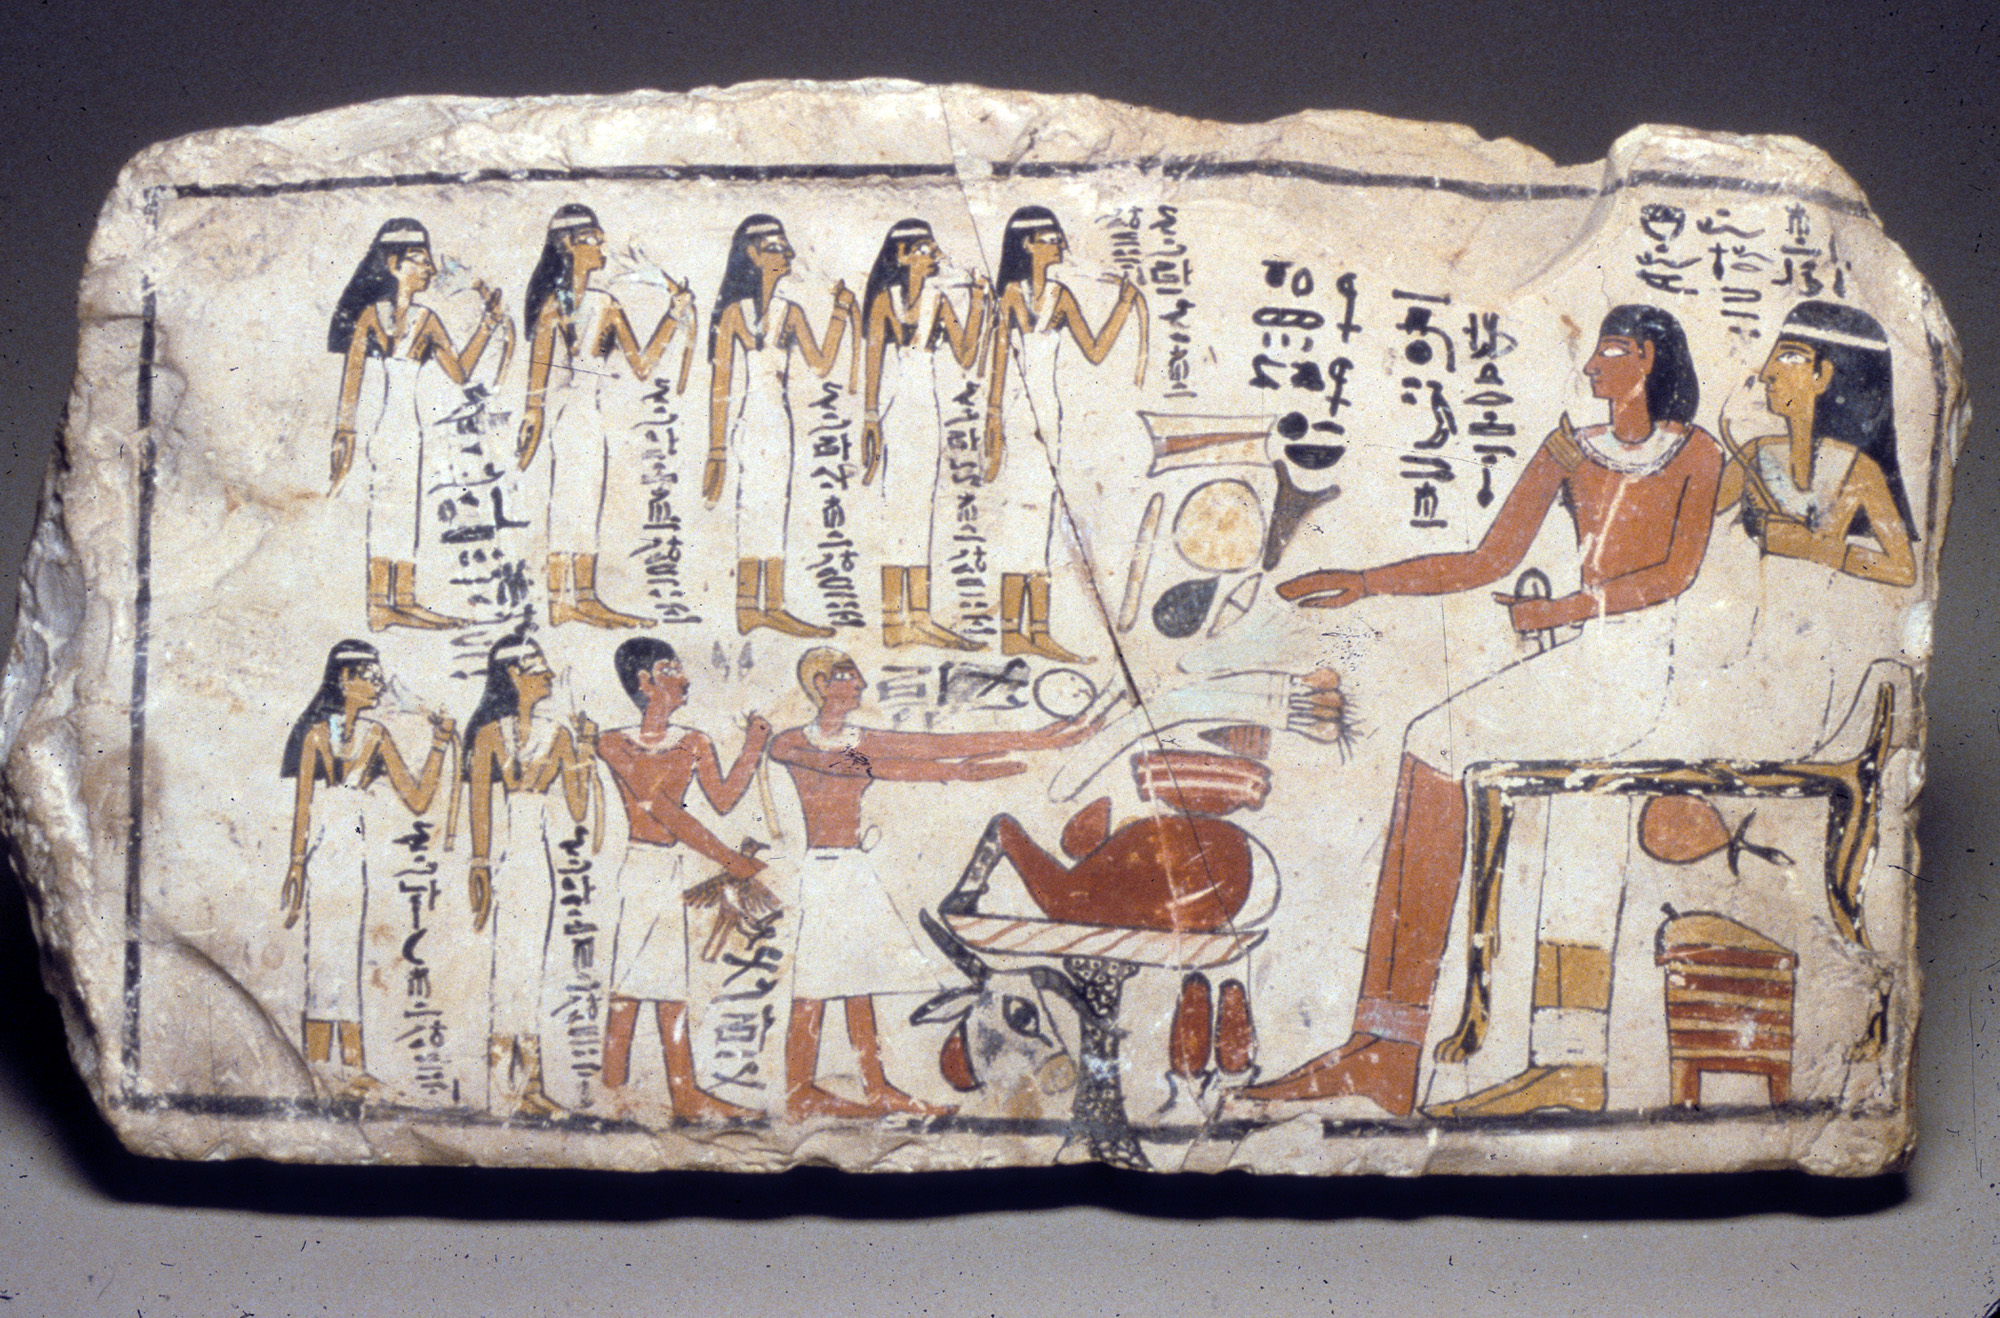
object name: stela, tetu, nefertjentet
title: Stela of Tetu and Nefertjentet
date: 2124-1981 BCE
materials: limestone, paint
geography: egypt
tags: women,hieroglyphs